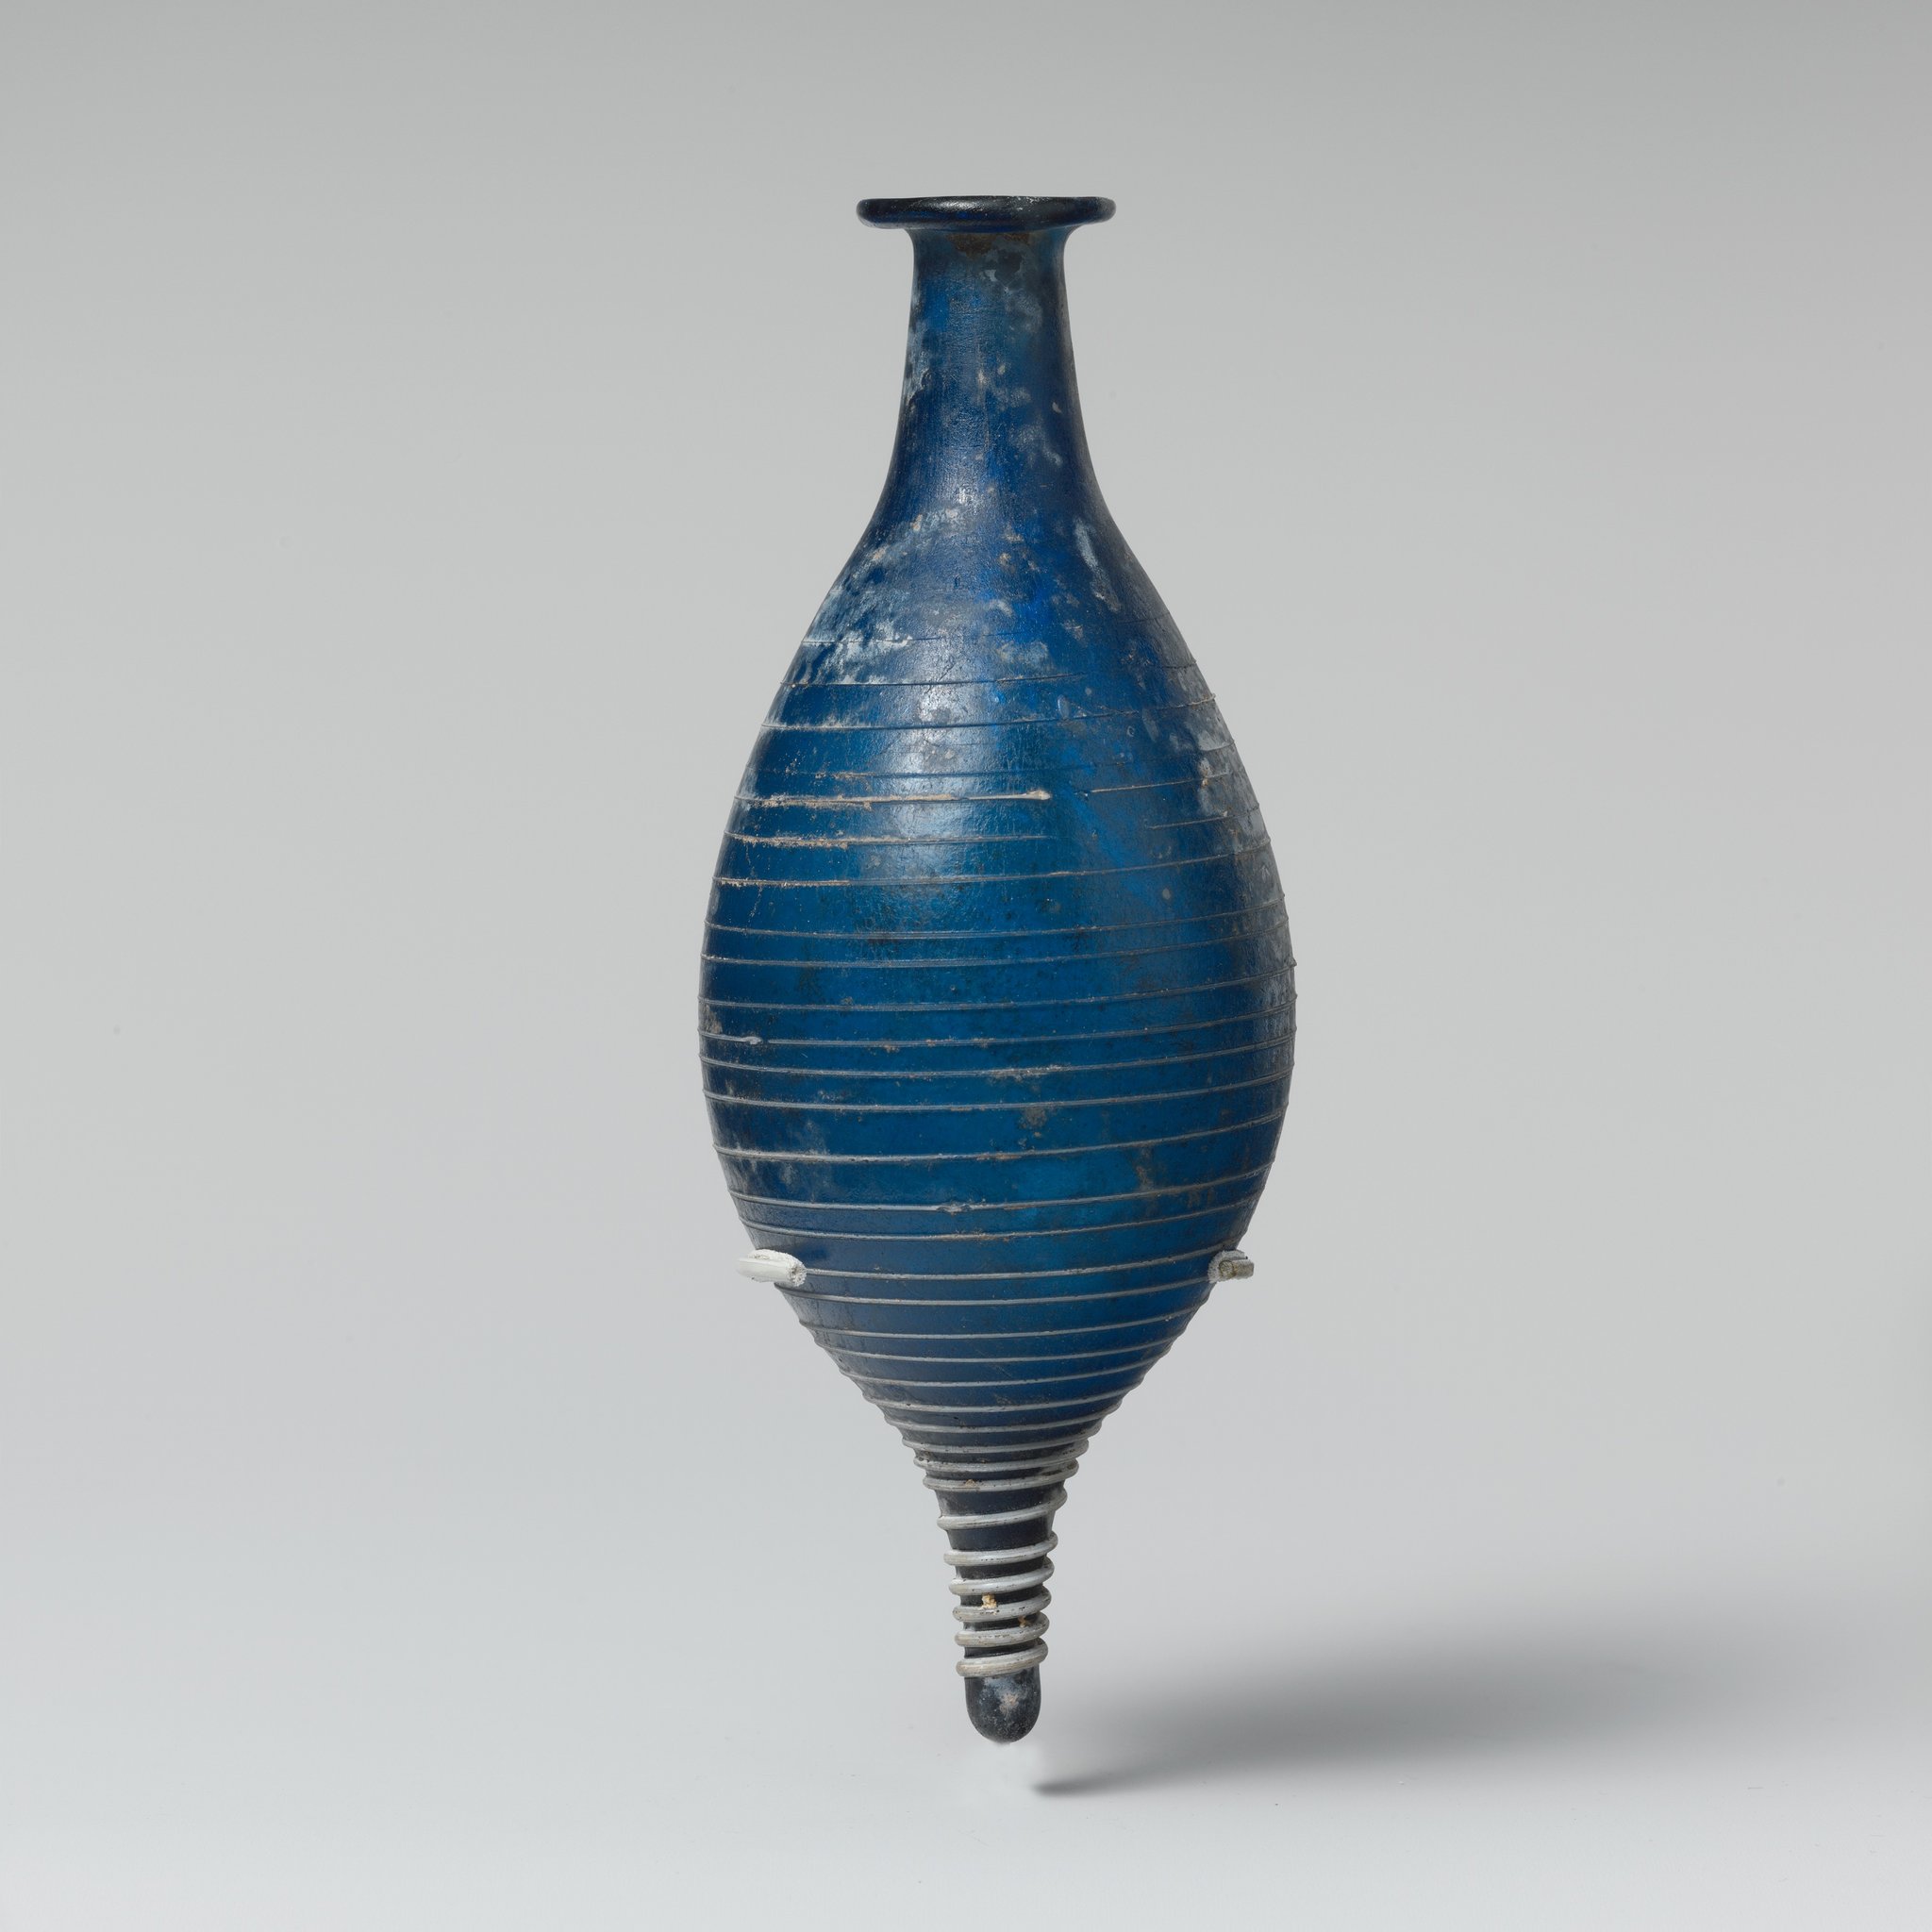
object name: perfume bottle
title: Glass perfume bottle with opaque white trail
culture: roman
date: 1-100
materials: glass